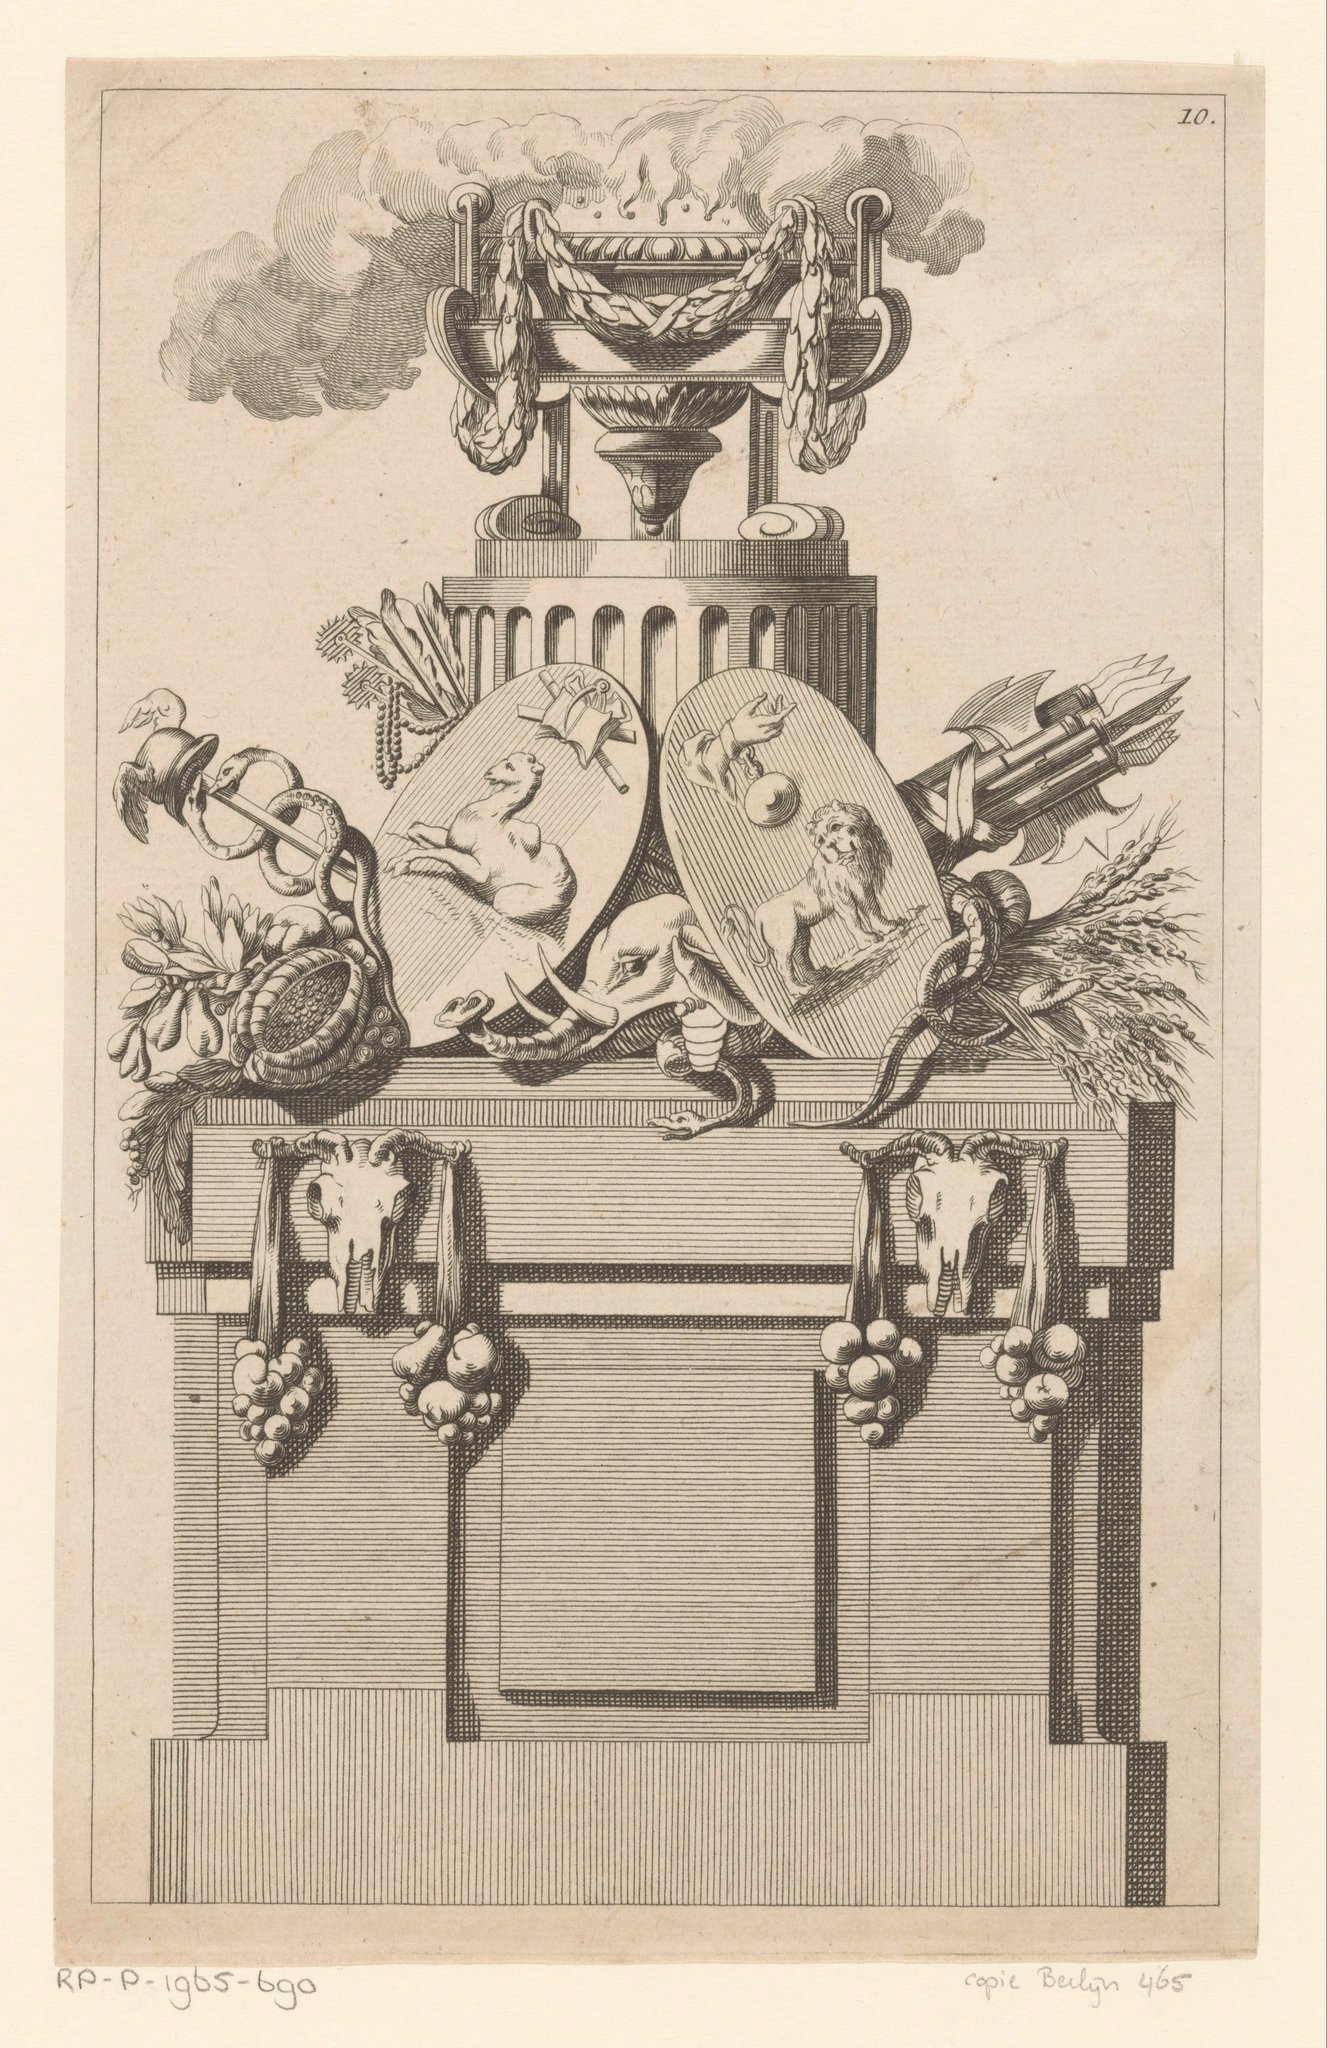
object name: print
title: Voetstuk met runderschedel en rookvat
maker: Anonymous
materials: paper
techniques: engraving, etching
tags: bucranium ~ ornament, pedestal of a piece of sculpture (perhaps in the form of a herm), incense-burner ~ scents, perfumes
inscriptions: collector's mark: Lugt 2228, collector's mark: Lugt 2760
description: Een voetstuk met runderschedels. Op het voetstuk liggen wapens, korenaren, slangen, een olifantenkop, fruit, een caduceus, schilden met een leeuw en een kameel en een rookvat. Rechts boven 10 genummerd.